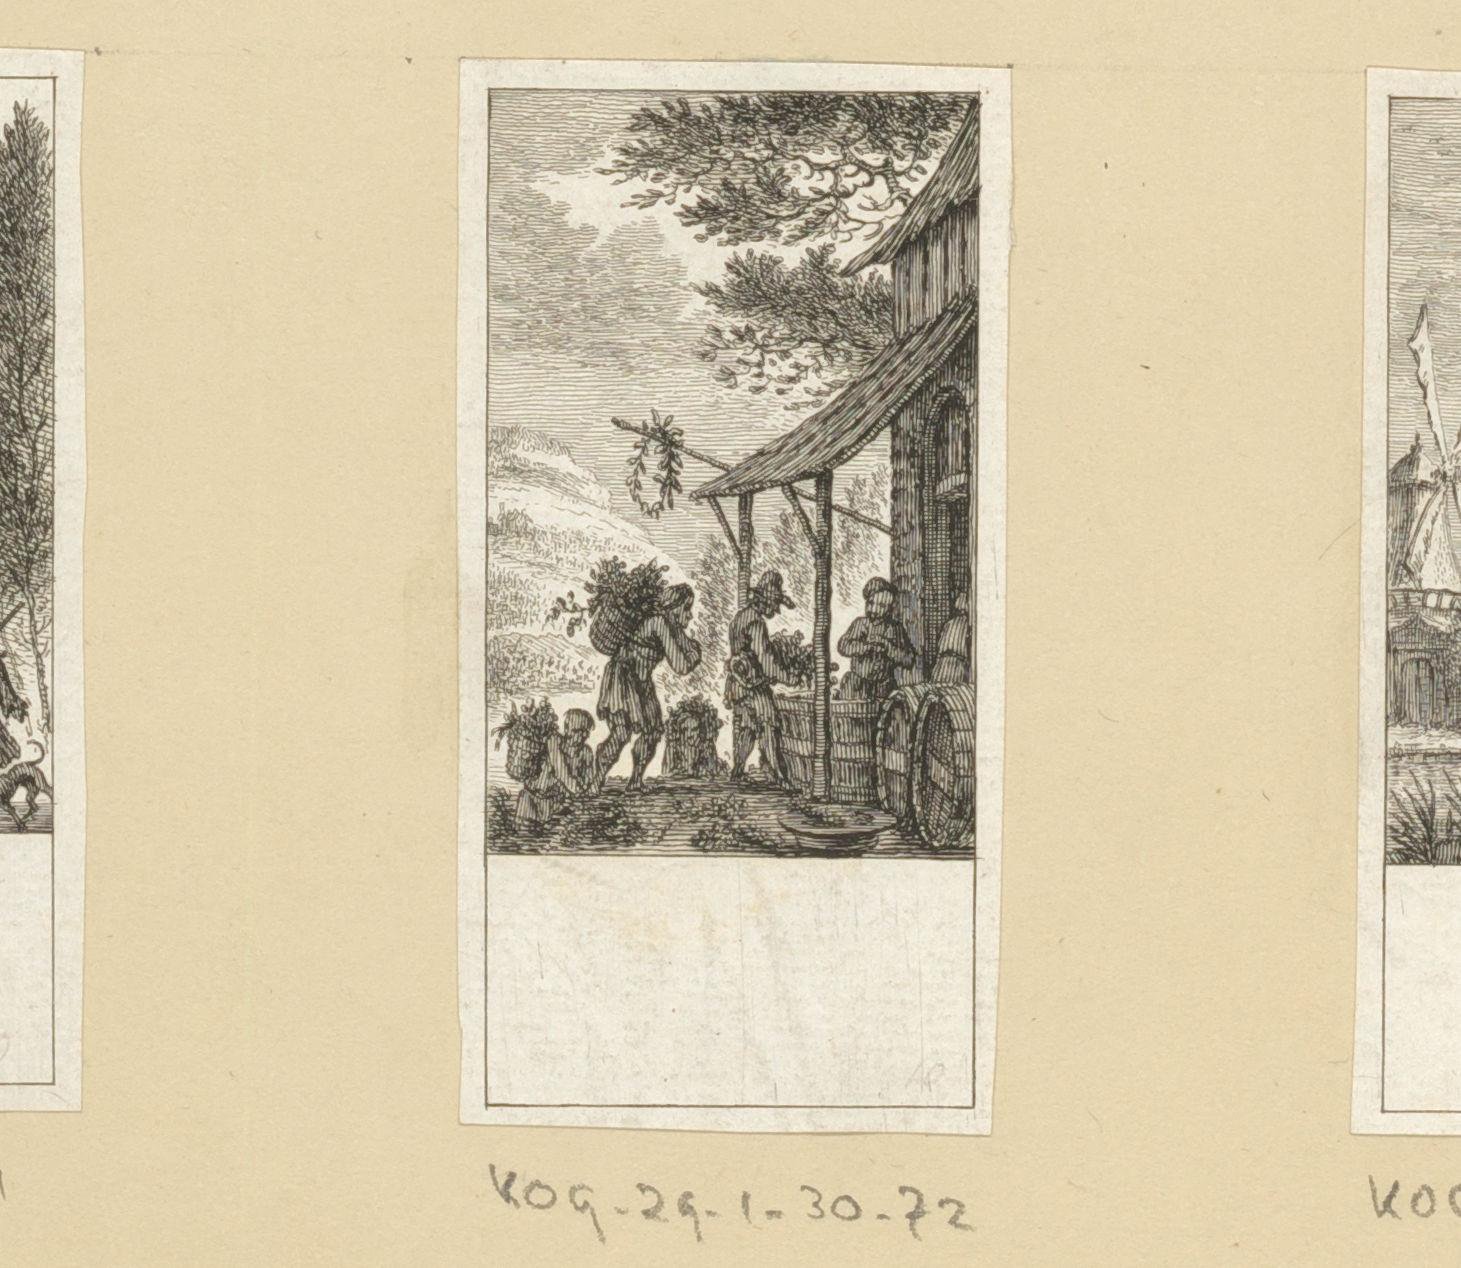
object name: print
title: Oktober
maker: simon fokke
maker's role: draughtsman, print maker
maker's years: 1712-1784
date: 1722-1784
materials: paper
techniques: etching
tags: october ~ other concepts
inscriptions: collector's mark: Lugt 1641, stamp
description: Uit een serie van twaalf prenten, de verbeelding van de maand oktober. Druivenoogst; druivenplukkers brengen manden vol druiven naar een houten vat voor de deur van een herberg. Onderwerpsrubrieken binnen de Atlas Zeden en Gewoonten: Zeden en Gewoonten in engeren zin. Volksleven. Zinnebeeldige voorstellingen uit het volkleven op serieprenten. Maanden en diversen (allegorieën).